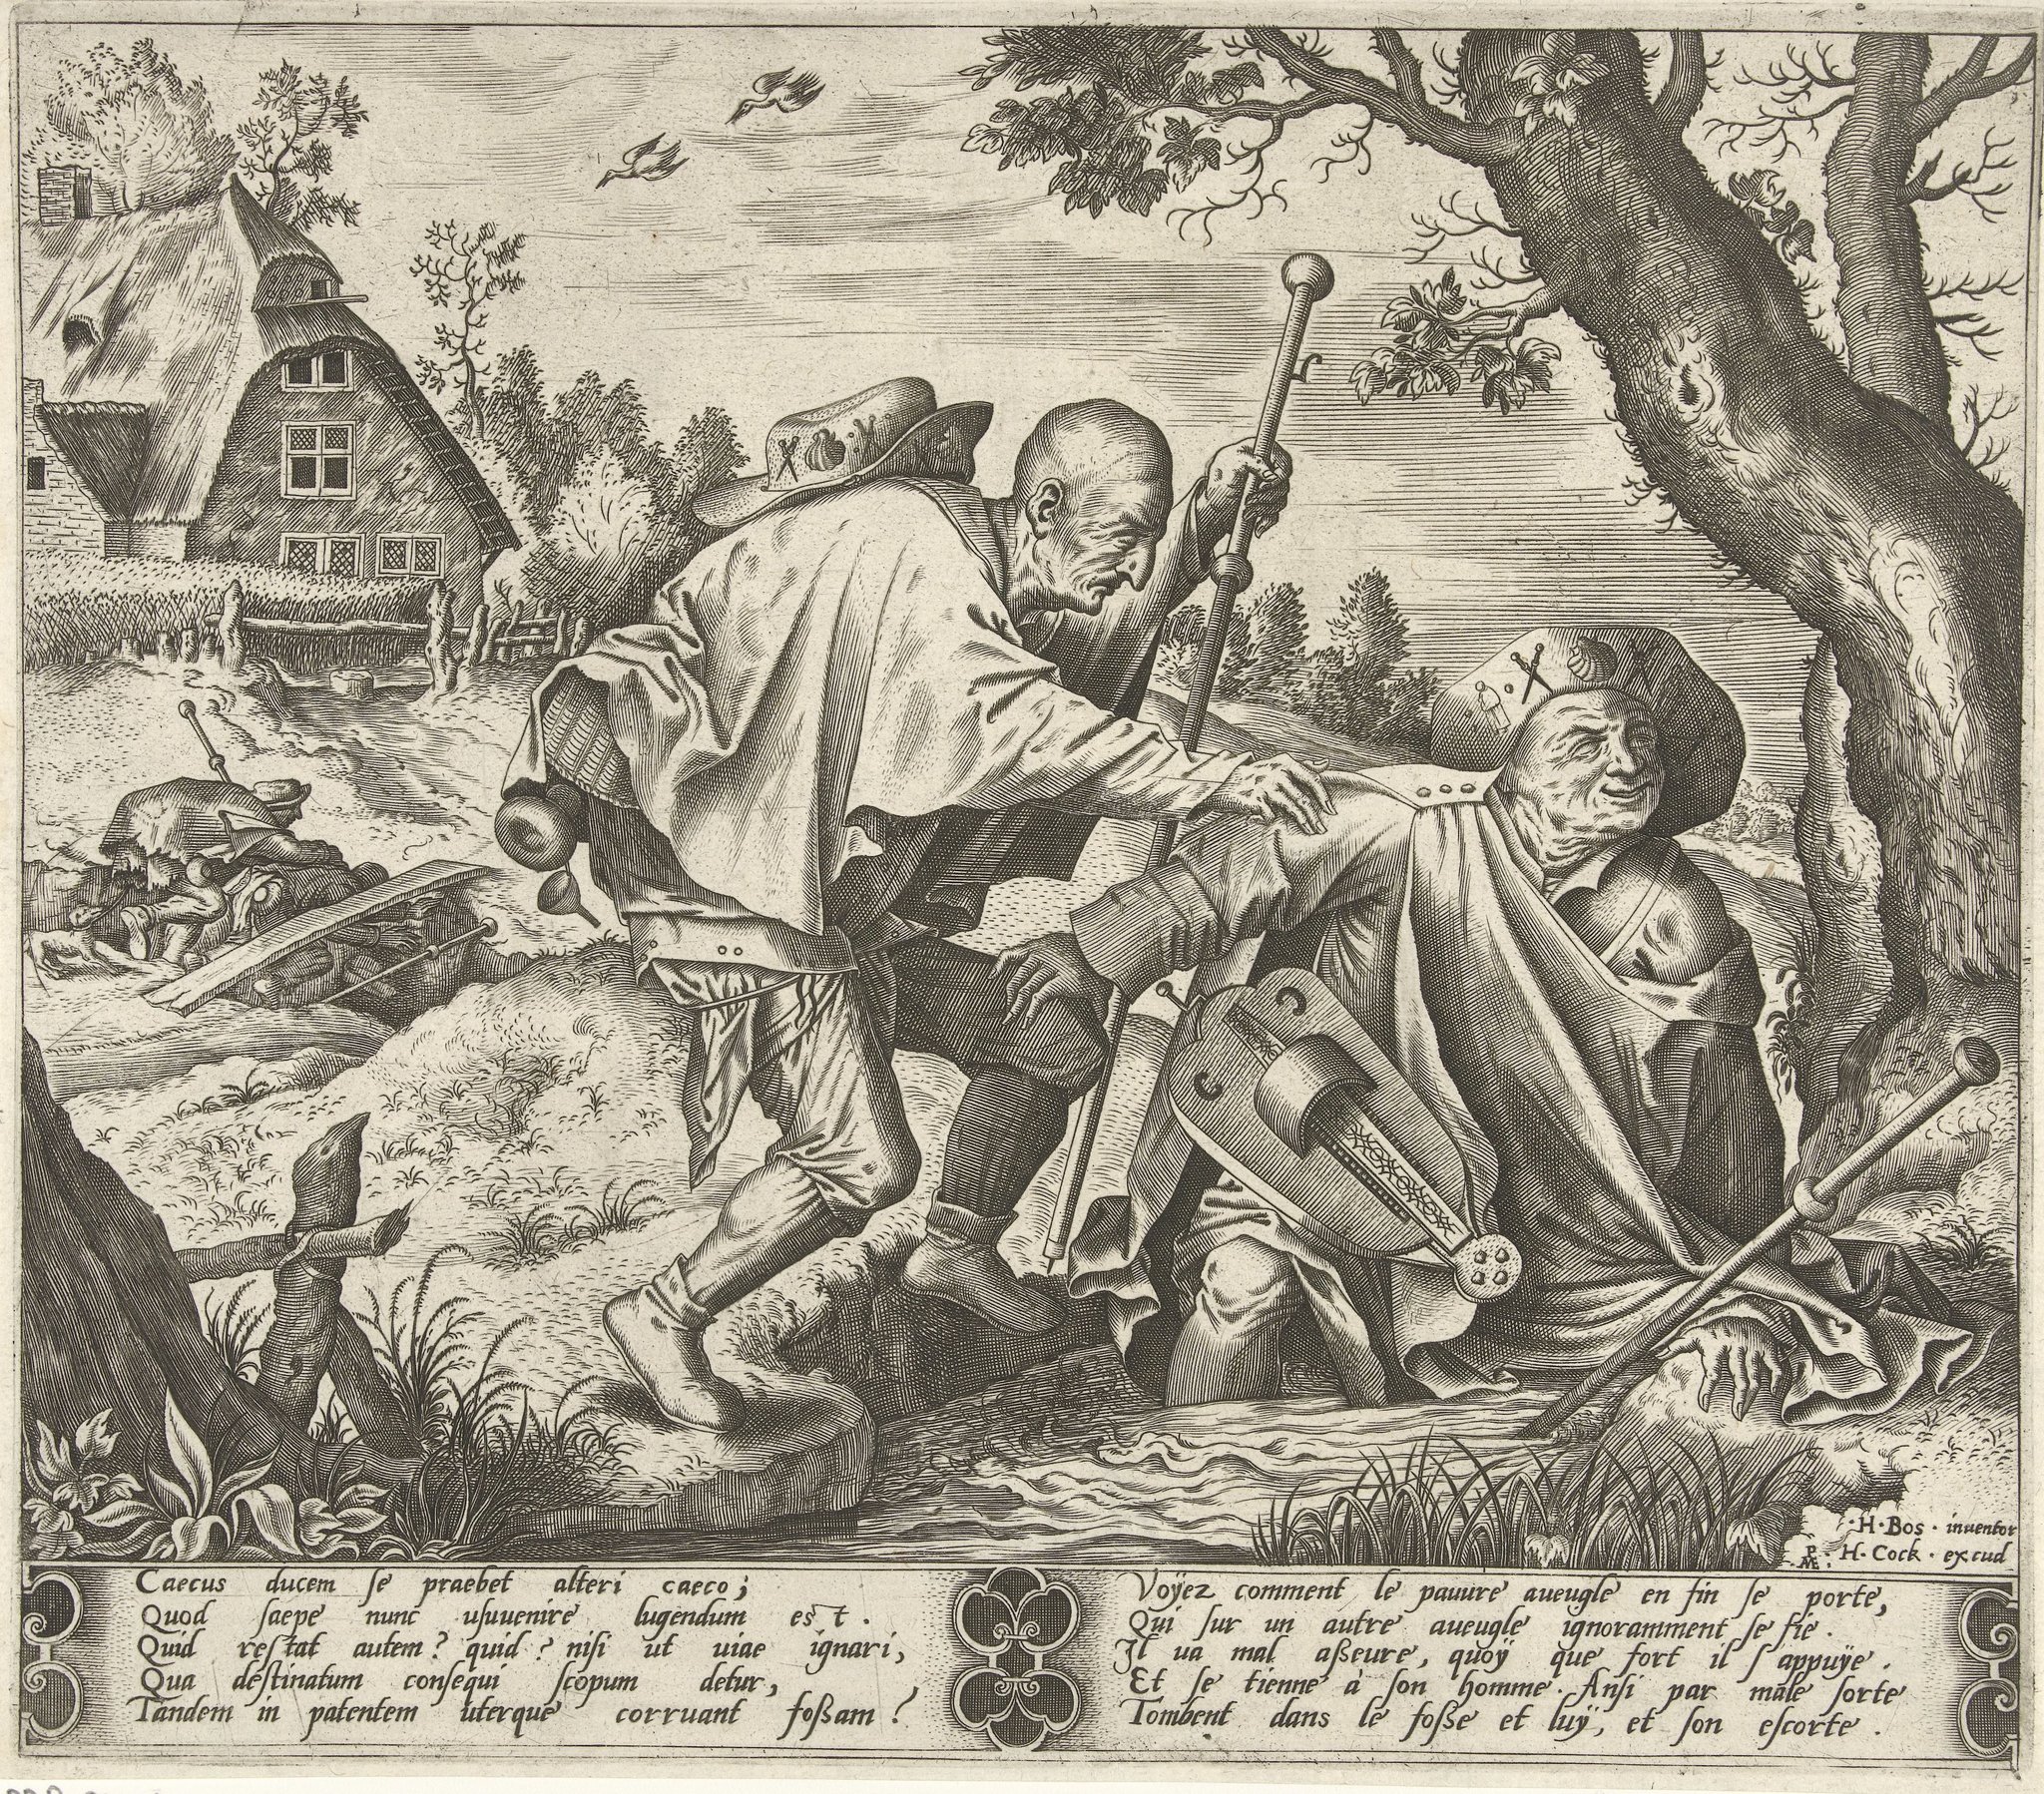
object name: print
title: Parabel van de twee blinden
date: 1540-1570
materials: paper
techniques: engraving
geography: antwerp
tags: the blind leading the blind (matthew 15:14), proverbs, sayings, etc.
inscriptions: collector's mark: Lugt 2228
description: De blinde leidsman loopt in het water en neemt daarbij zijn eveneens blinde volgeling mee in zijn val. Verbeelding van het spreekwoord en de parabel: als de ene blinde de andere leidt, vallen ze allebei in een kuil. Waarvan de betekenis luidt: wanneer onbekwamen andere onbekwamen adviseren, gaat het fout. Verwijzing naar Mat. 15:14. Op de achtergrond een huis en nogmaals twee blinden die vallen. Onder de voorstelling de strekking van het spreekwoord in een vijfregelig vers; rechts in het Latijn en links in het Frans.